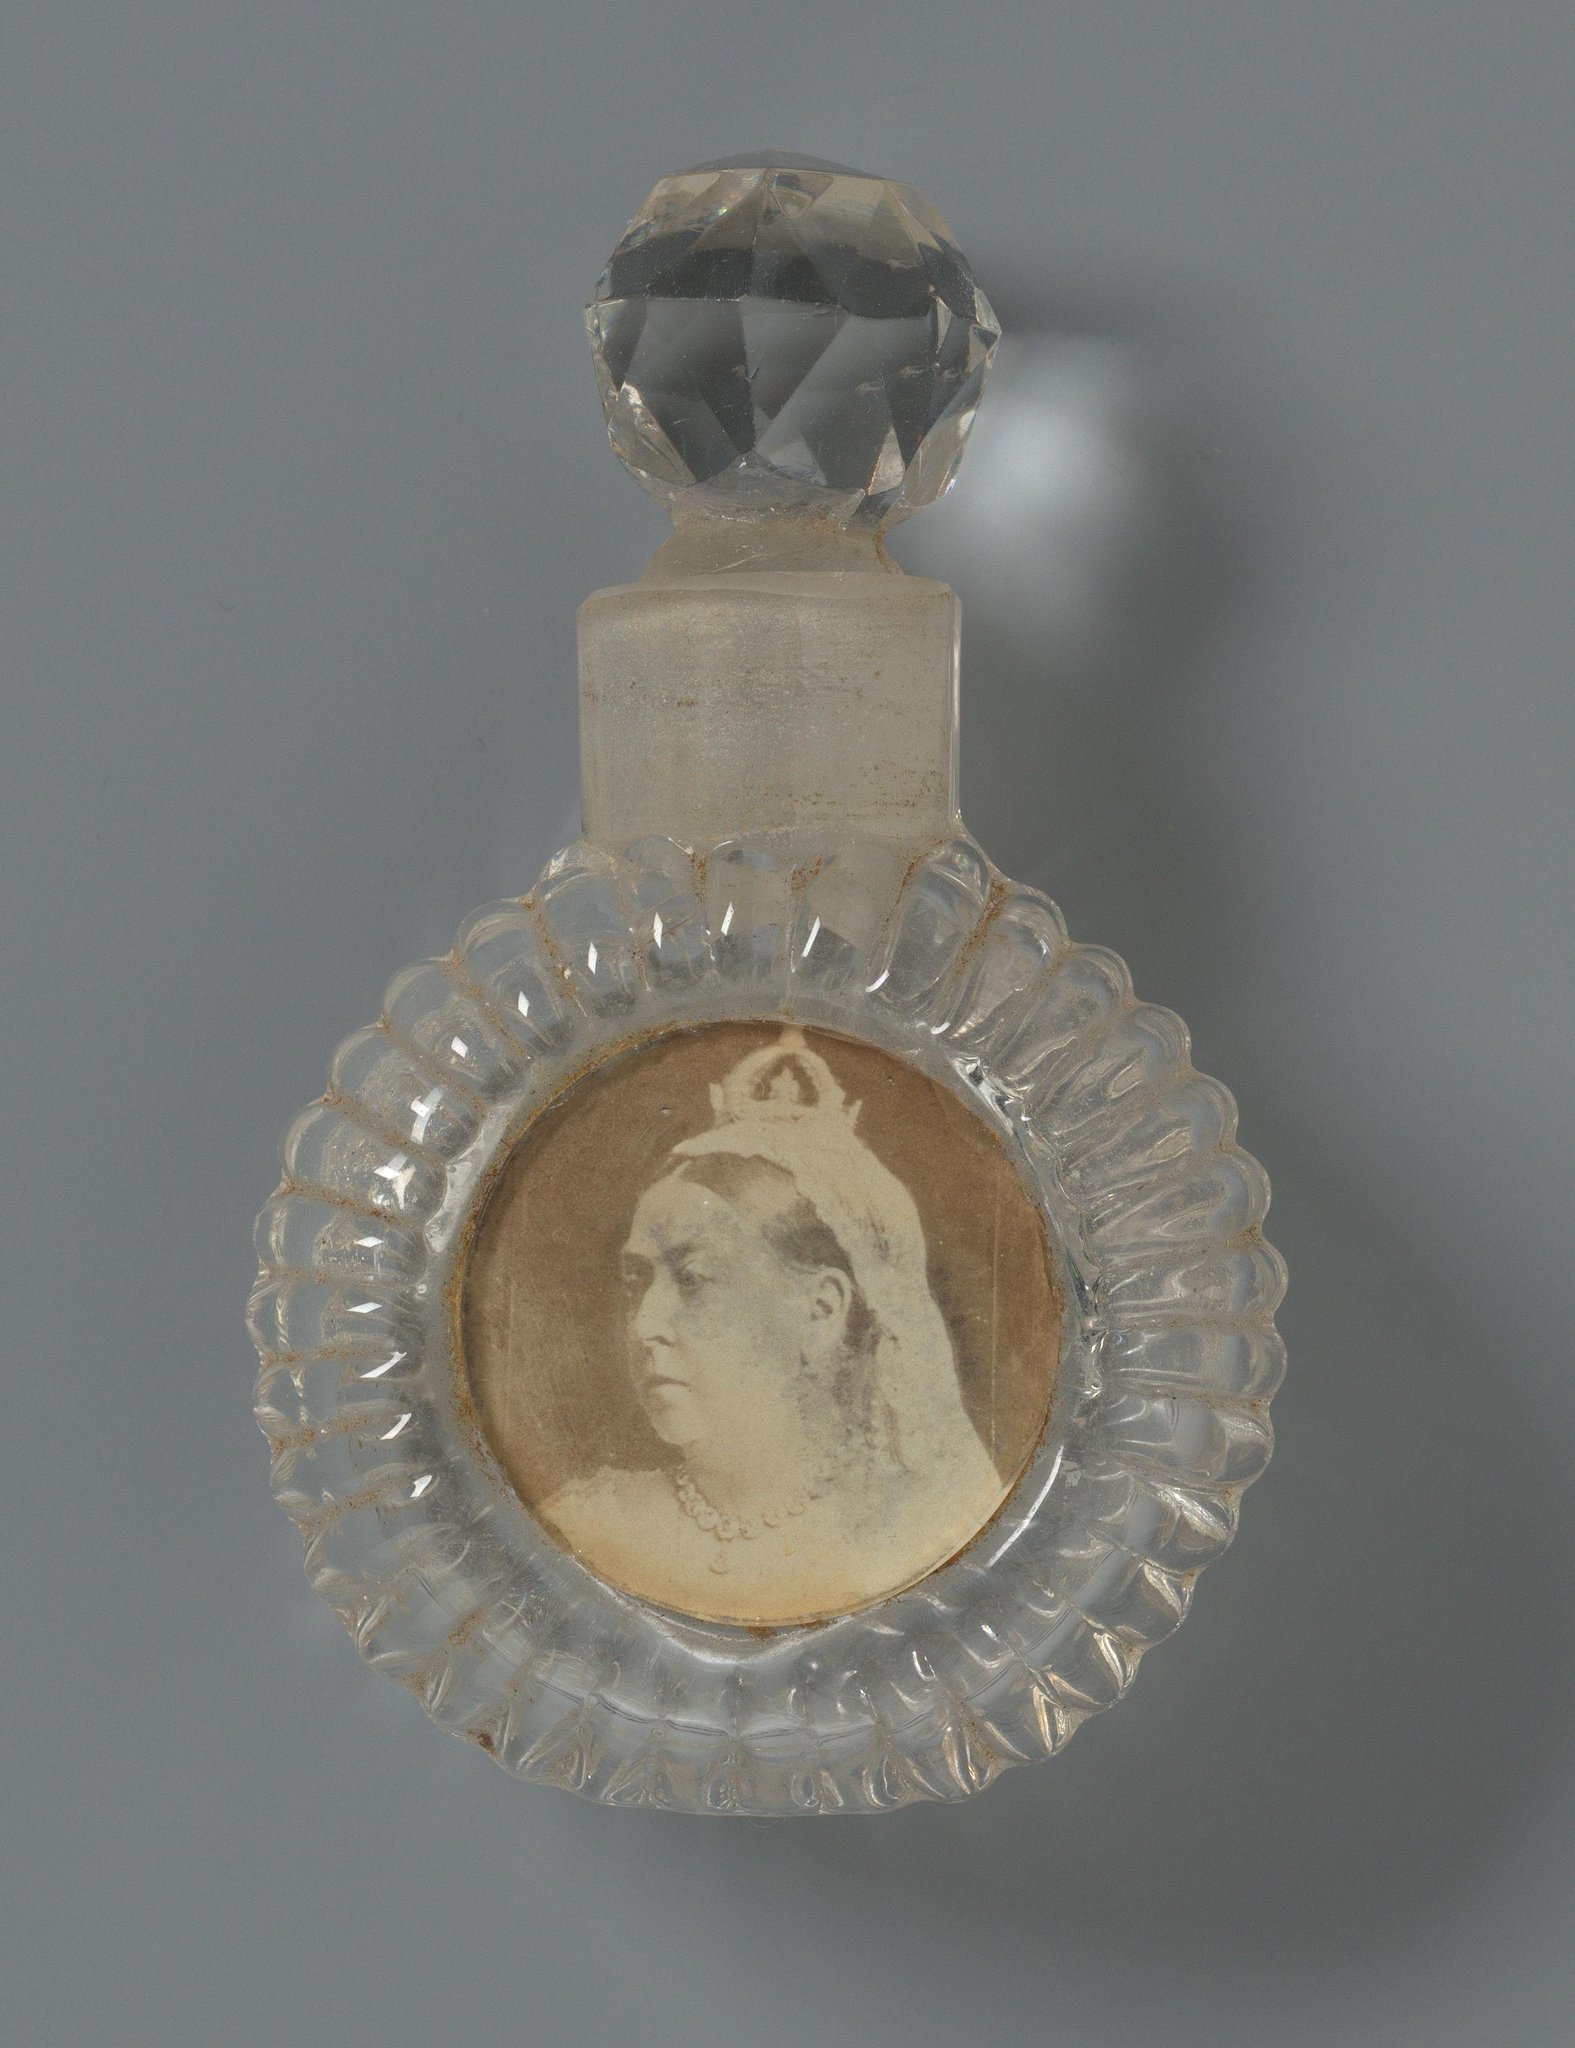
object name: drug jar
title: Portret van koningin Victoria op miniatuurstopfles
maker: Anonymous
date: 1870-1900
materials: glass, paper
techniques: albumen print, grinding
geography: great britain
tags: victoria (koningin van het verenigd koninkrijk en keizerin van india), historical persons, queen, great britain